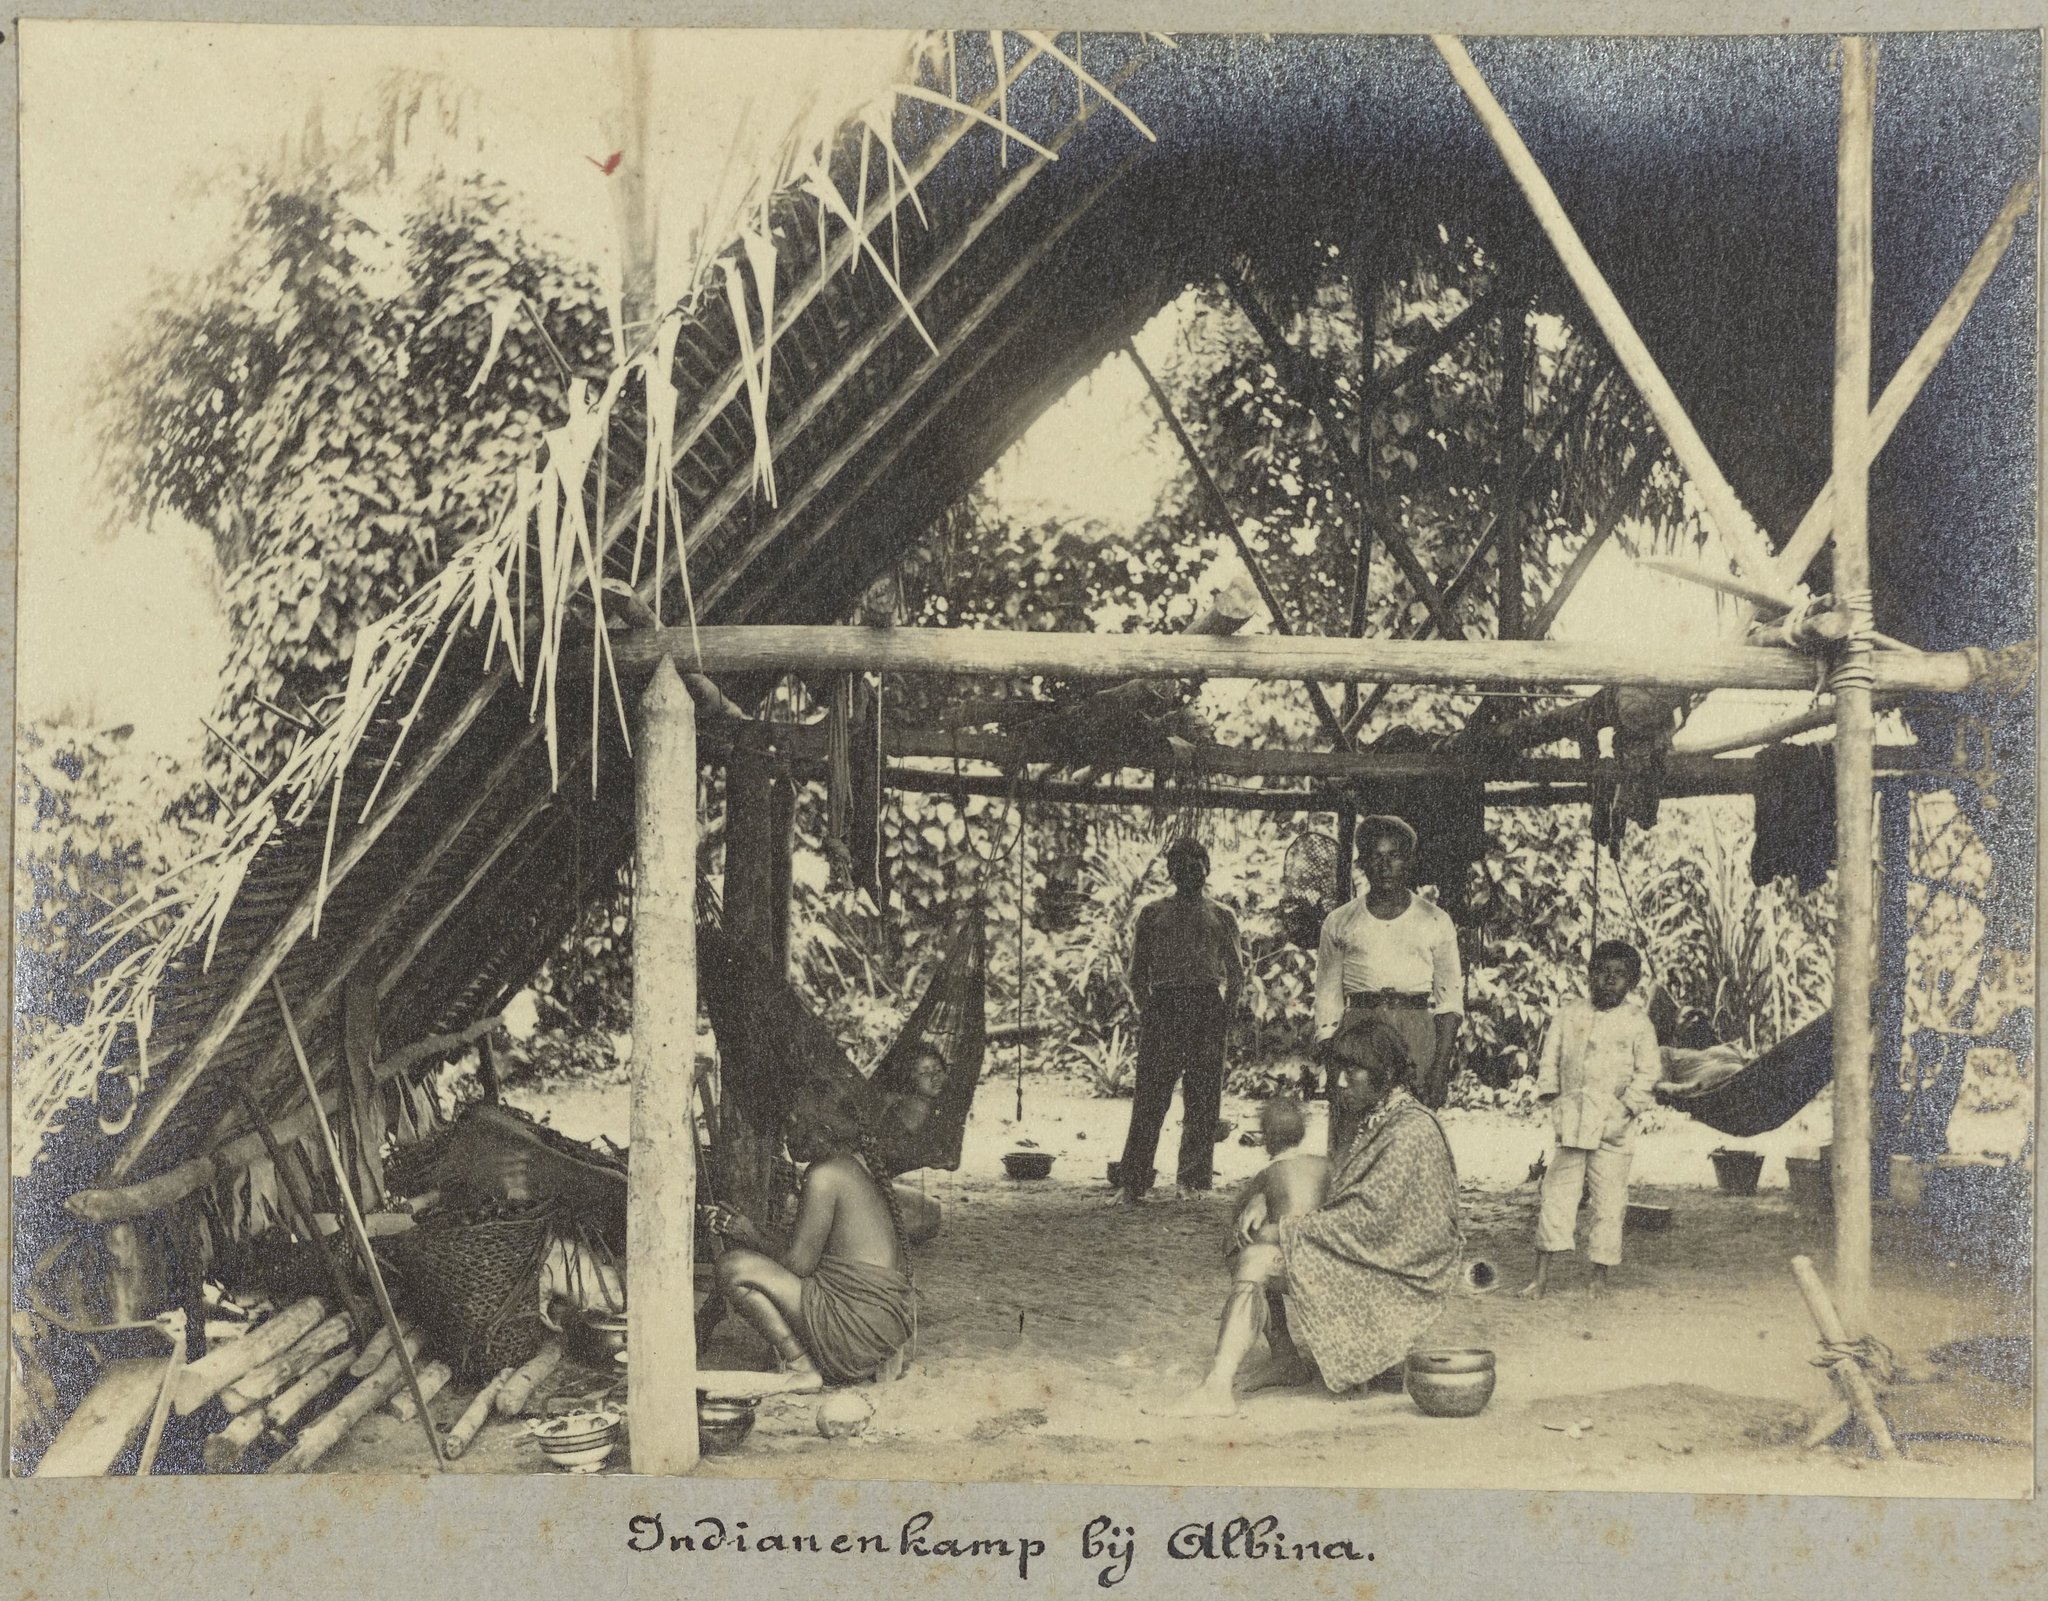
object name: photograph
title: Familie in een woning bij Albina, Suriname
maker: hendrik doijer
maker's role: engineer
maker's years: 1863-1925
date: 1903-1910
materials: photographic support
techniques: gelatin silver print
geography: suriname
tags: indian lodge, indigenous peoples of south america, suriname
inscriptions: inscription: ‘B8 / Indianenkamp bij Albina.’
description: Familie in een woning in een kamp bij Albina. De mannen, vrouwen en kinderen zijn nazaten van de oorsronkelijke bevolking van Suriname. Onderdeel van het fotoalbum van de familie Doijer, Souvenir de Voyage (deel 1), in en rond de plantage Ma Retraite in Suriname in de jaren 1903-1910.